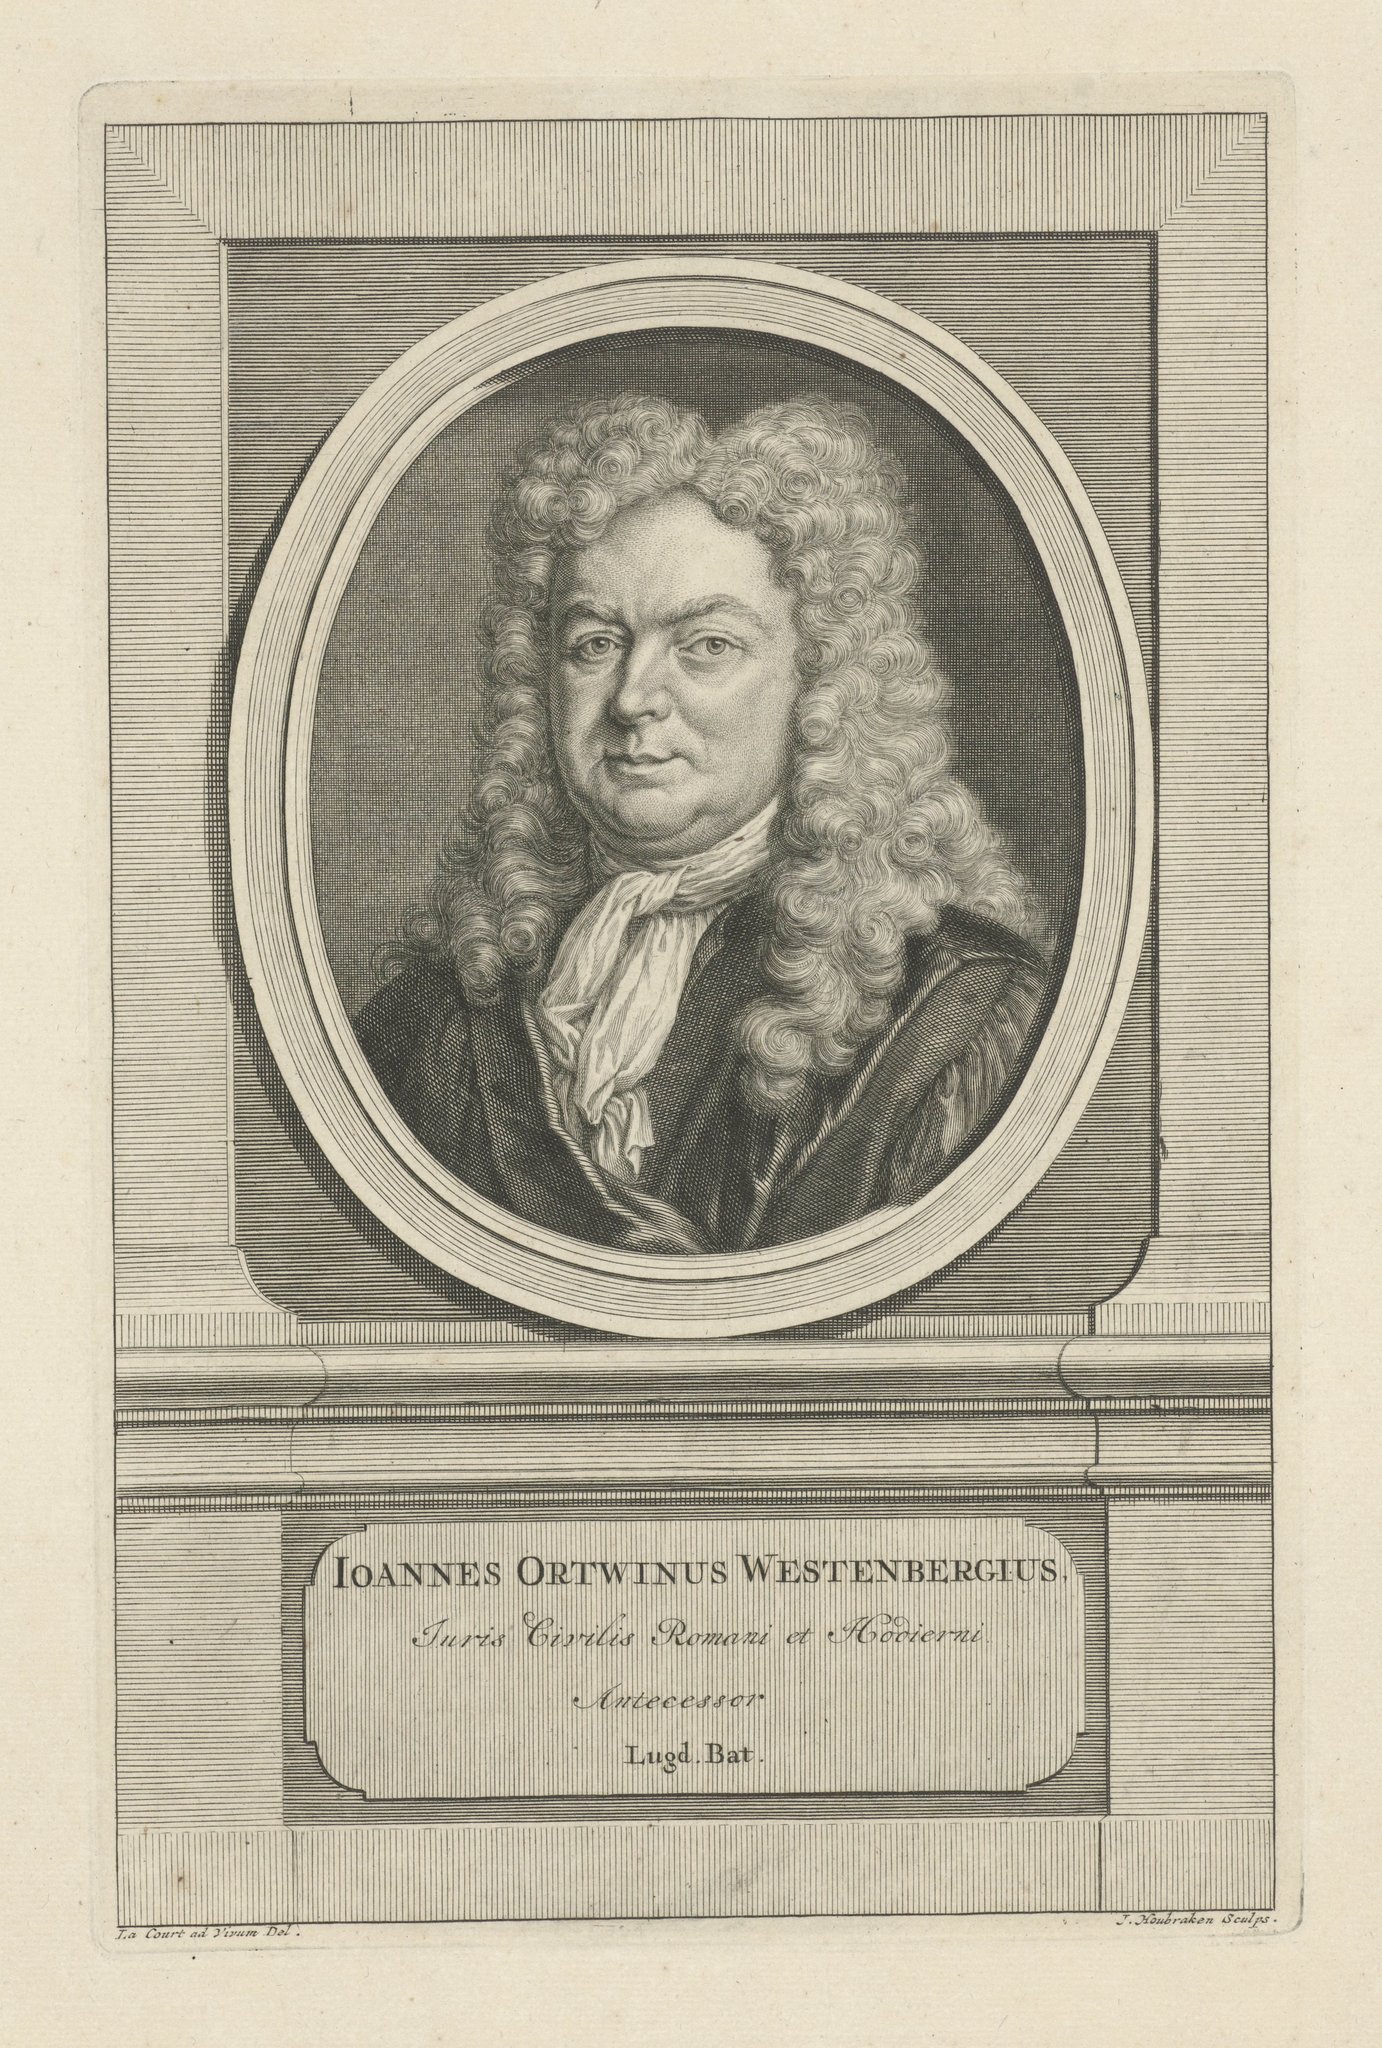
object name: print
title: Portret van Johannes Ortwinus Westenberg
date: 1723-1780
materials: paper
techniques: engraving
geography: amsterdam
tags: leiden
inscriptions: collector's mark: Lugt 240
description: Portret van Johannes Ortwinus Westenberg in een ovaal, tegen een architectonische wand. Onder het portret een plaquette met de naam van de geportretteerde en zijn gegevens in vier regels in het Latijn.